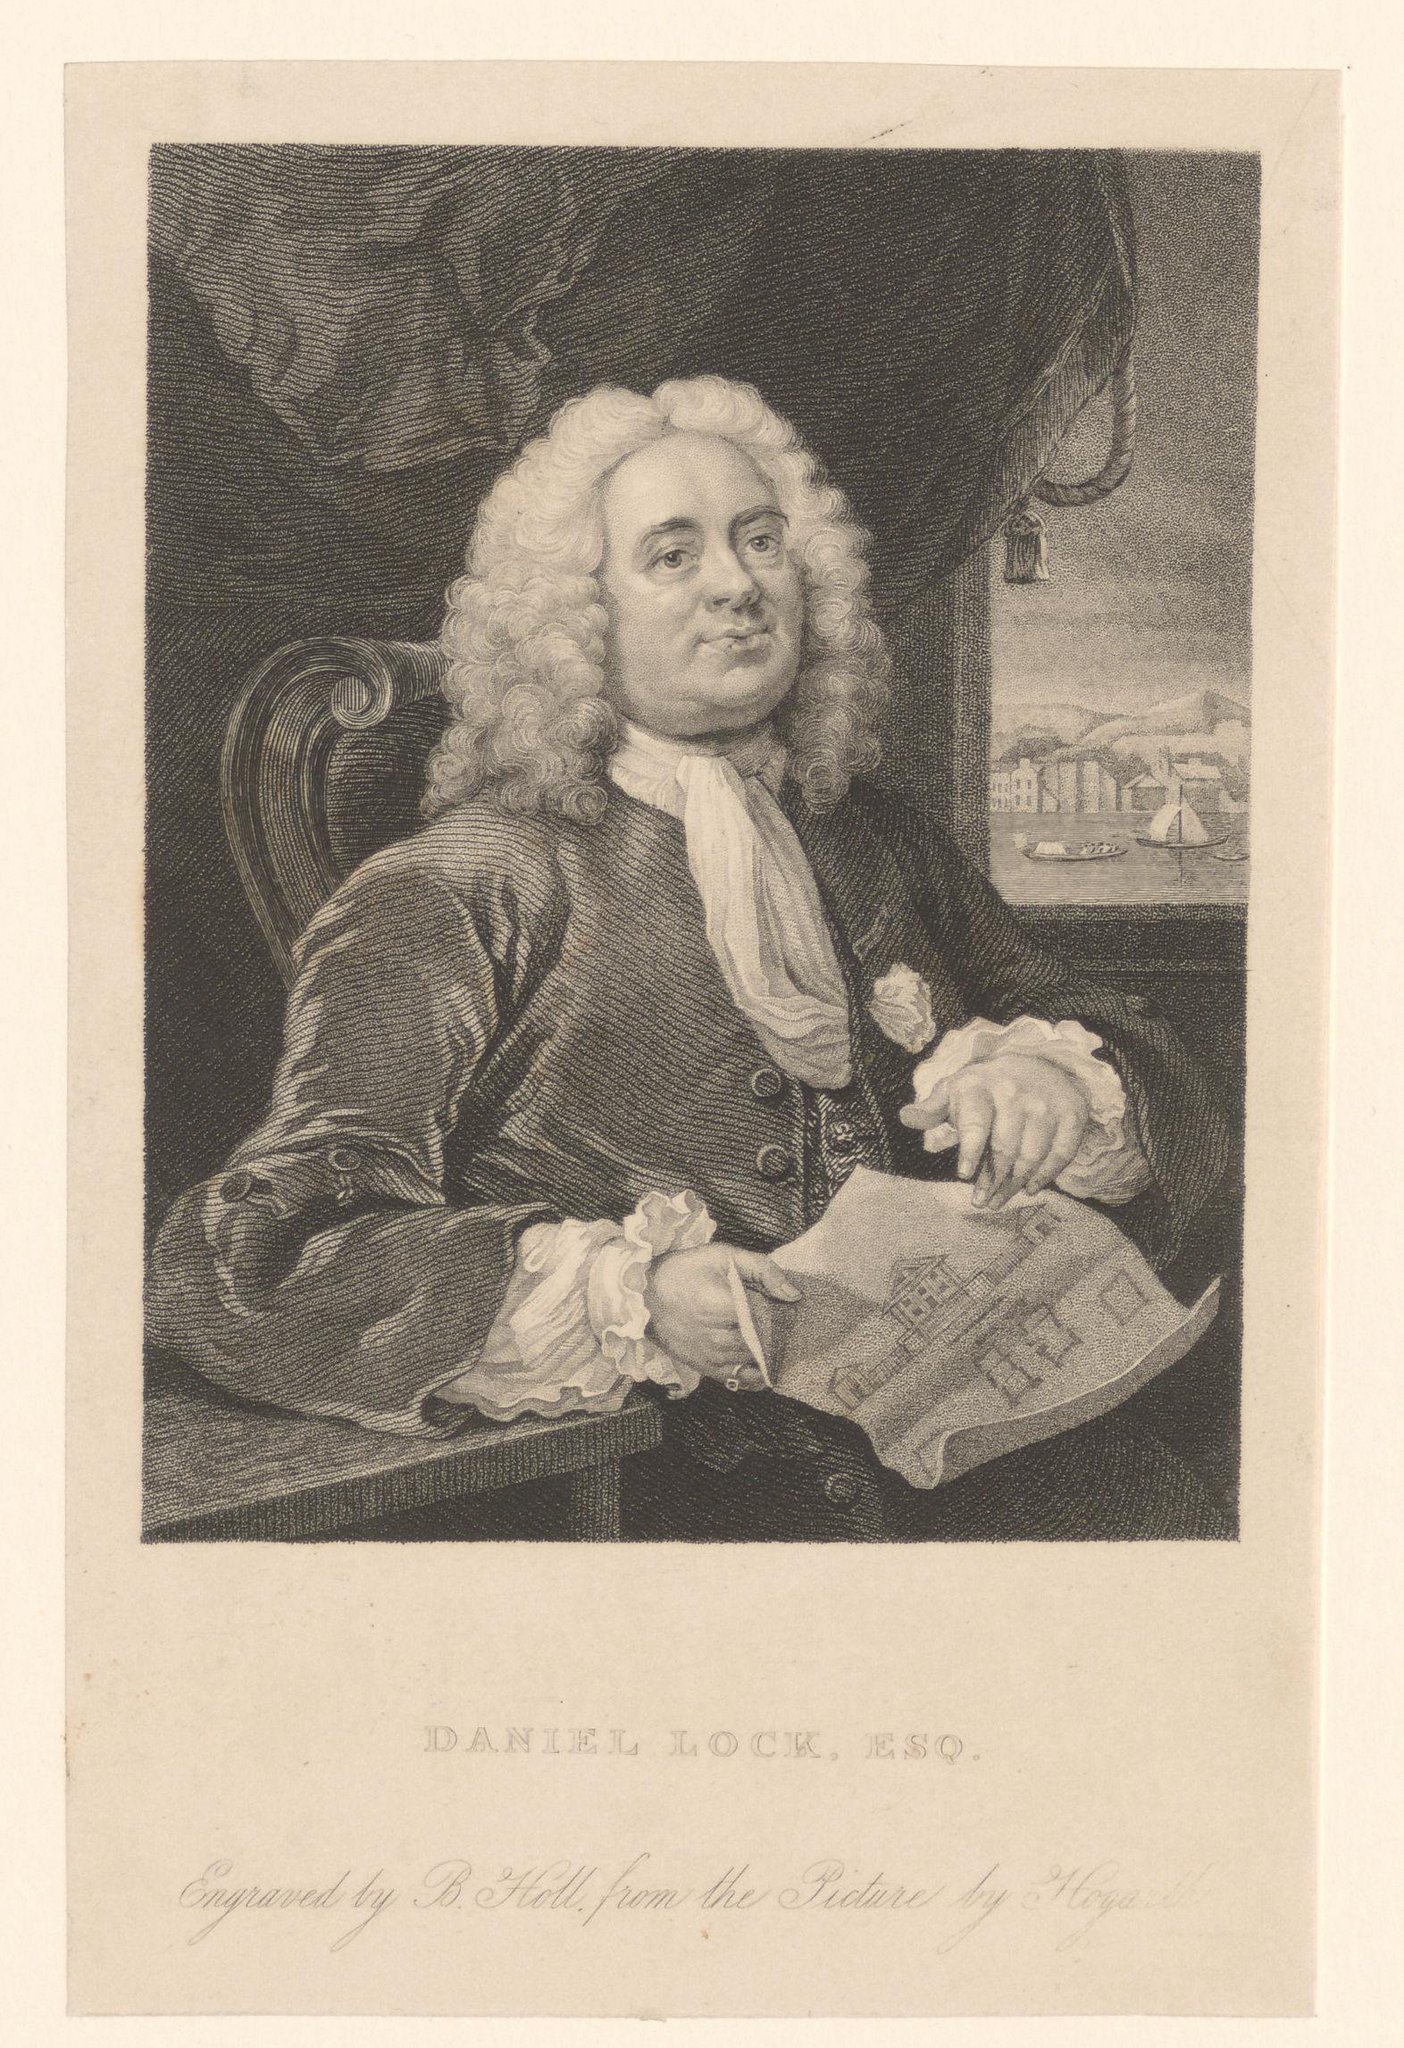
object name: print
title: Portret van Daniel Lock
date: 1818-1836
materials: paper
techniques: etching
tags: historical persons, portrait, self-portrait of architect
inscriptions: collector's mark: Lugt 2228